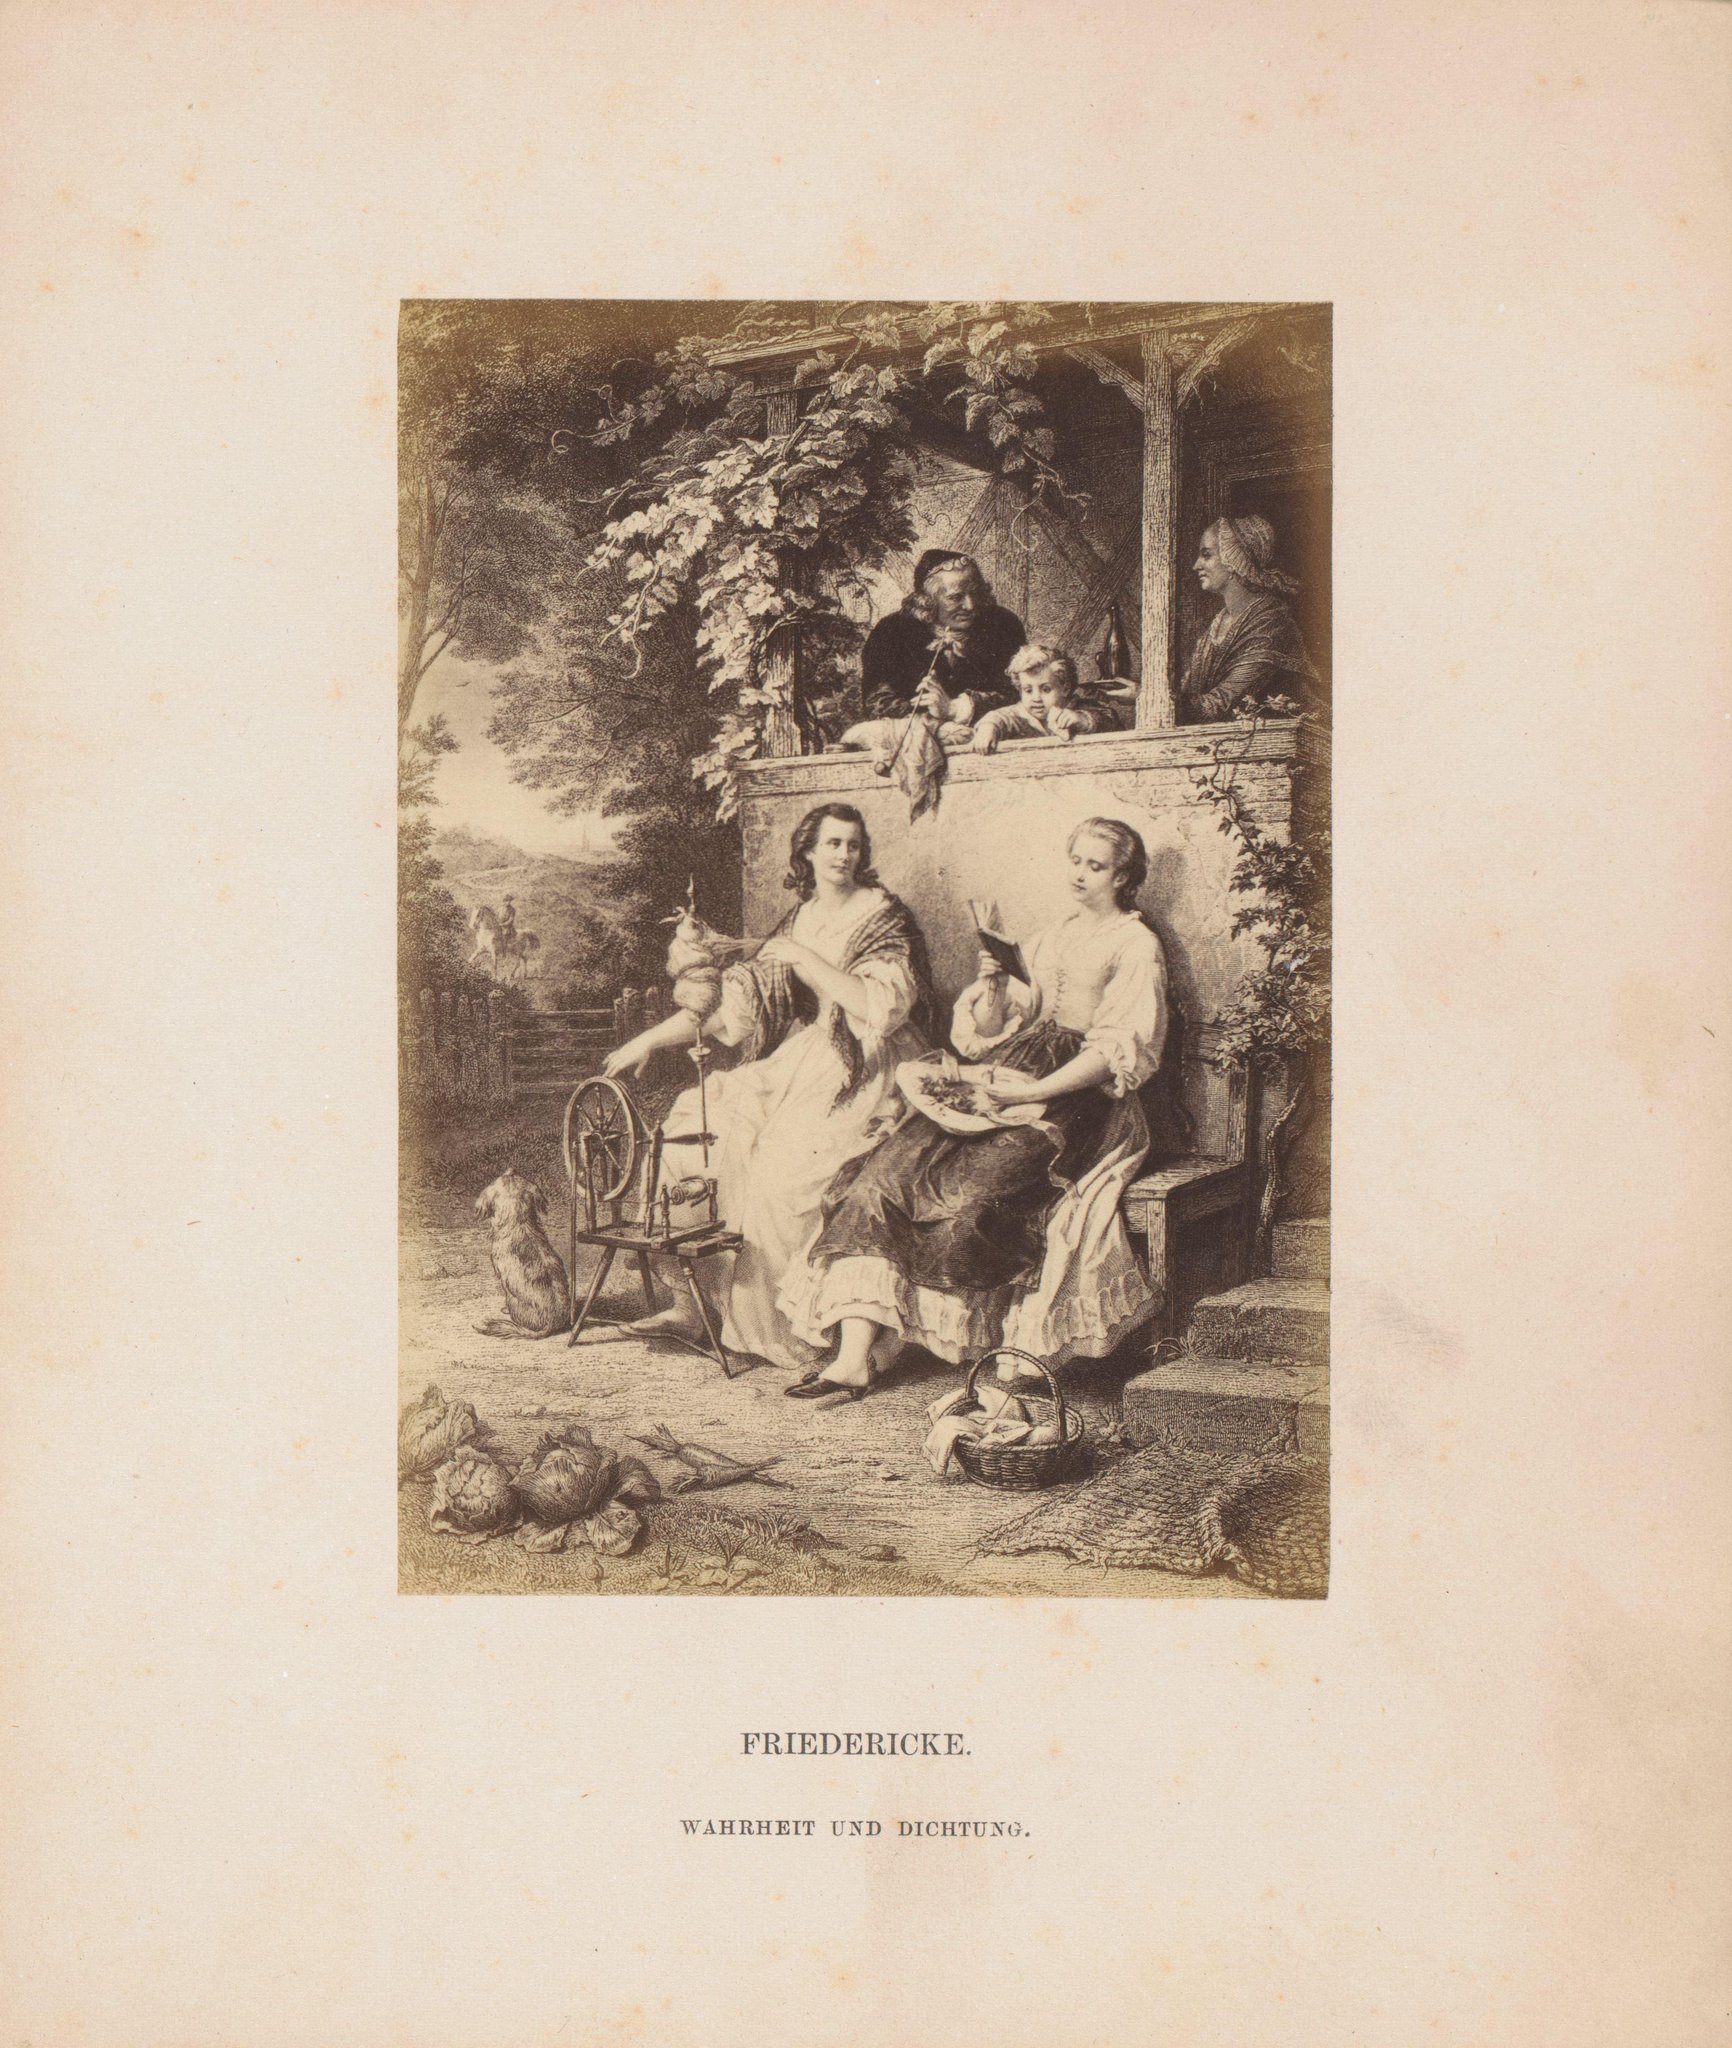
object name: photograph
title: Fotoreproductie van een tekening van Friederike uit Goethe's Dichtung und Wahrheit door Wilhelm von Kaulbach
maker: Anonymous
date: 1850-1900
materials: cardboard, photographic support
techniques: albumen print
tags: reading, spindle (+ women (labourers)), specific works of literature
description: Deze foto maakt deel uit van een omslag met 22 foto's.